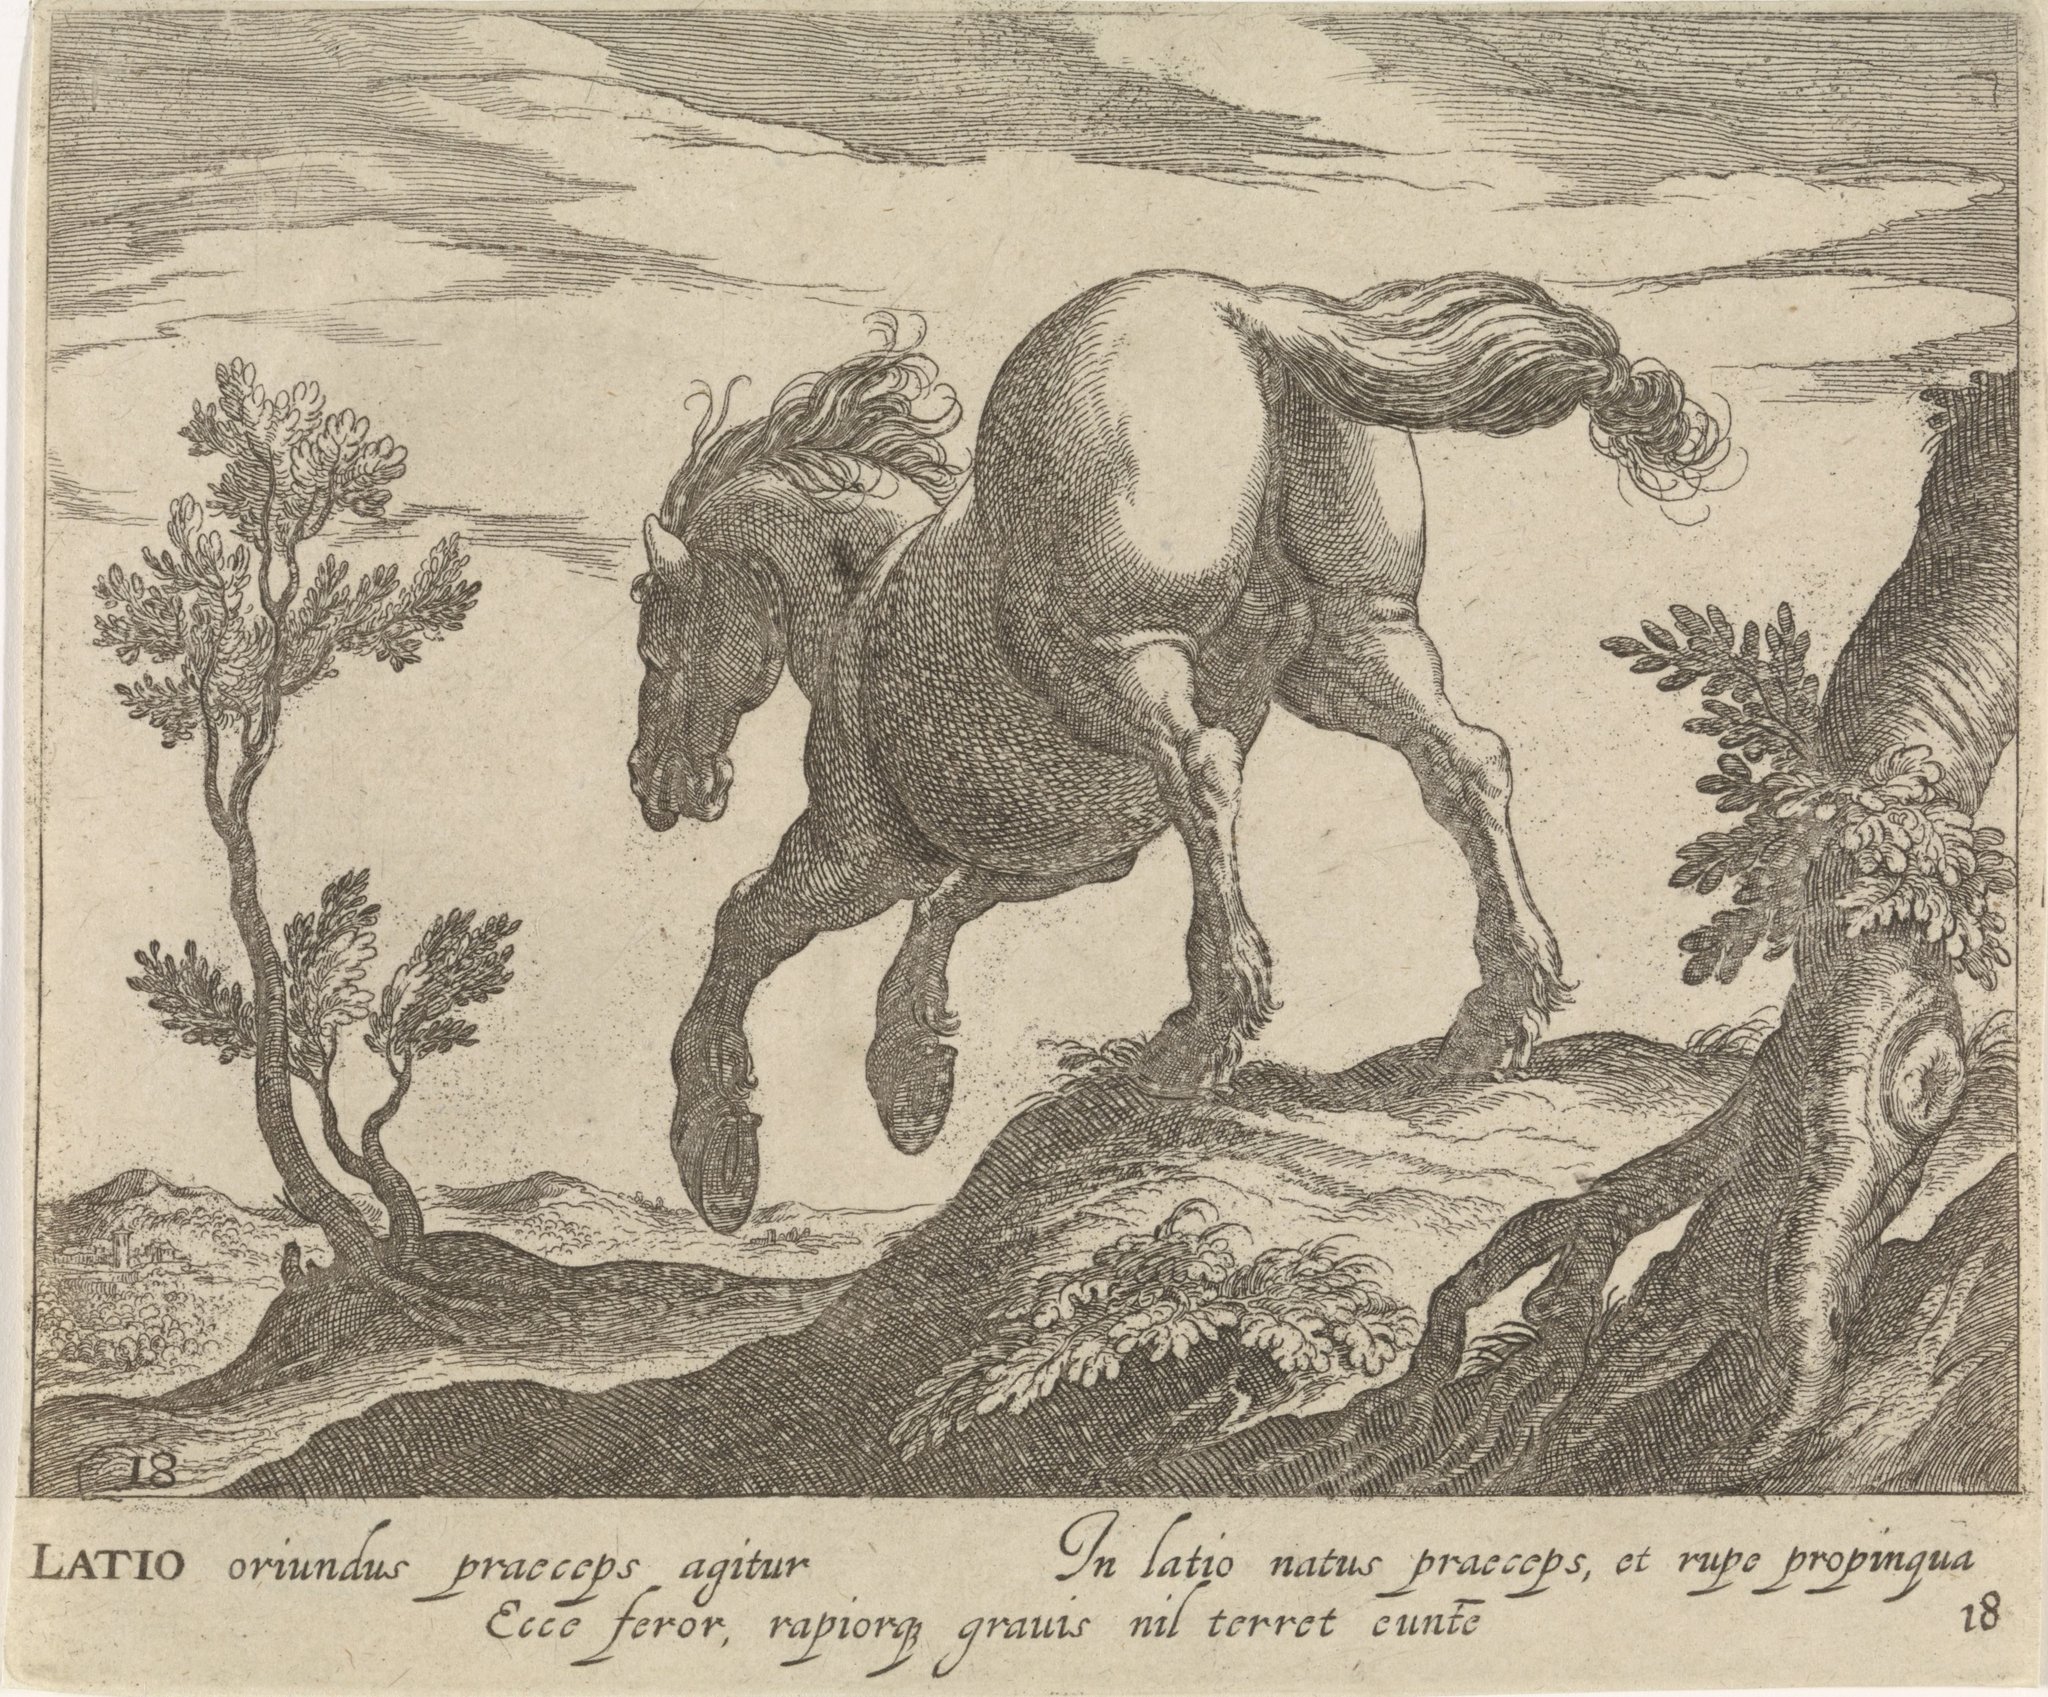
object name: print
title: Paardenrassen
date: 1590-1637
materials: paper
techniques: engraving, etching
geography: amsterdam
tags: horse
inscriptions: collector's mark: Lugt 2228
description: Heuvelachtig landschap met galopperend paard, naar links gewend, op de rug gezien. In de marge een tweeregelig onderschrift in het Latijn. Prent uit een serie van dertig met paardenrassen.